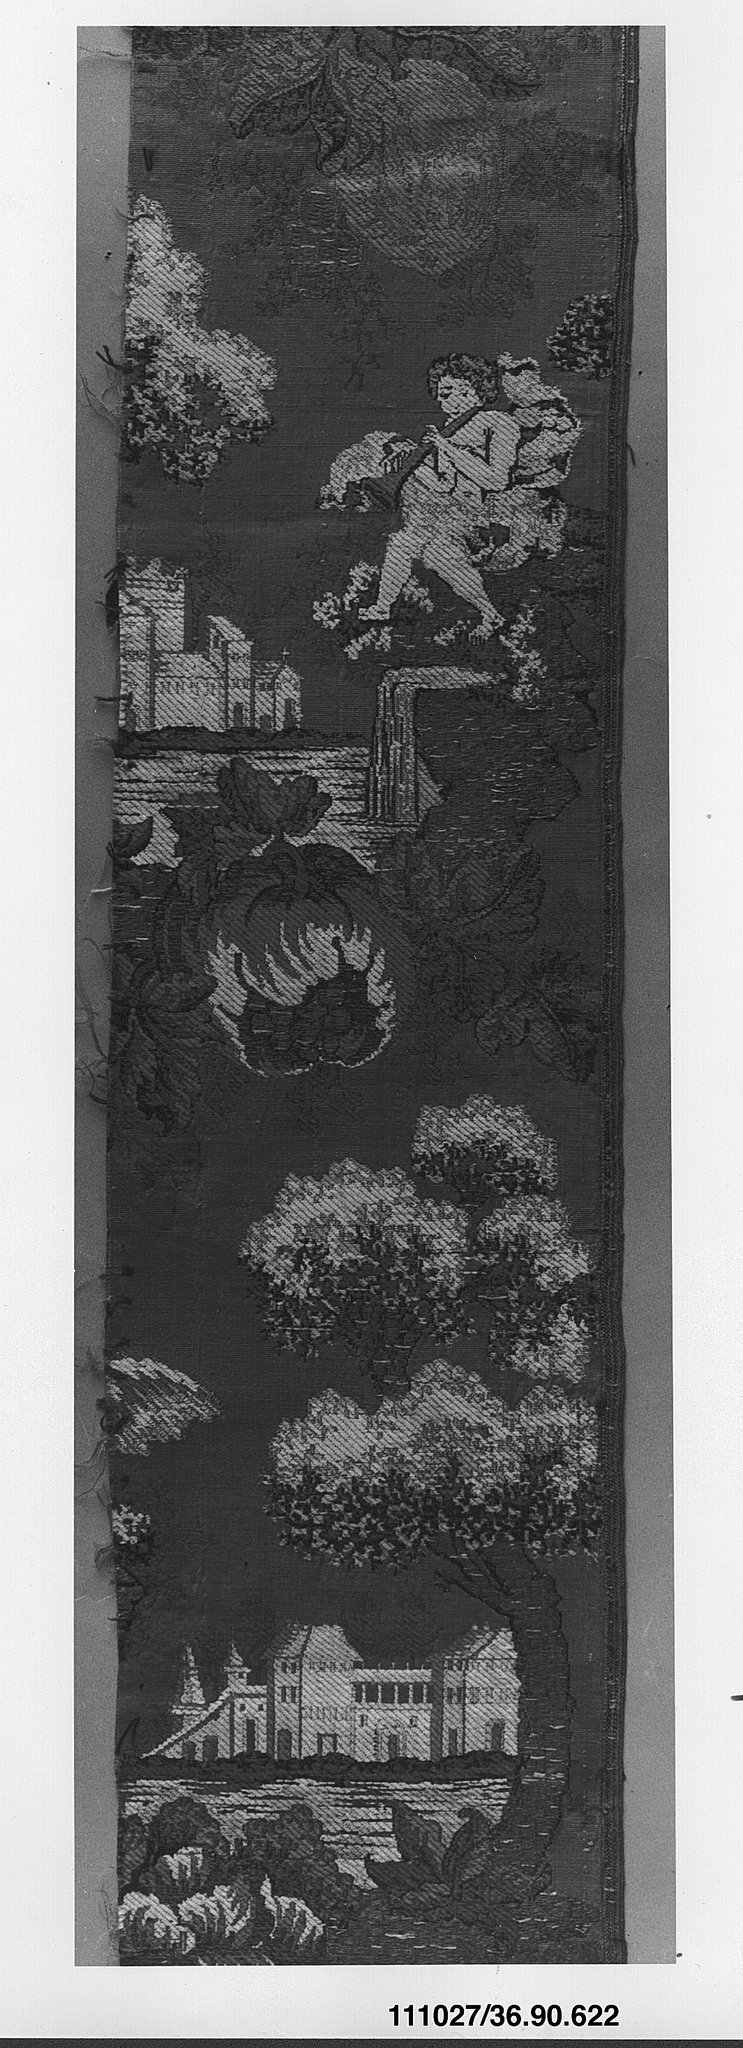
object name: piece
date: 1735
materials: metal thread, silk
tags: buildings,flowers,trees